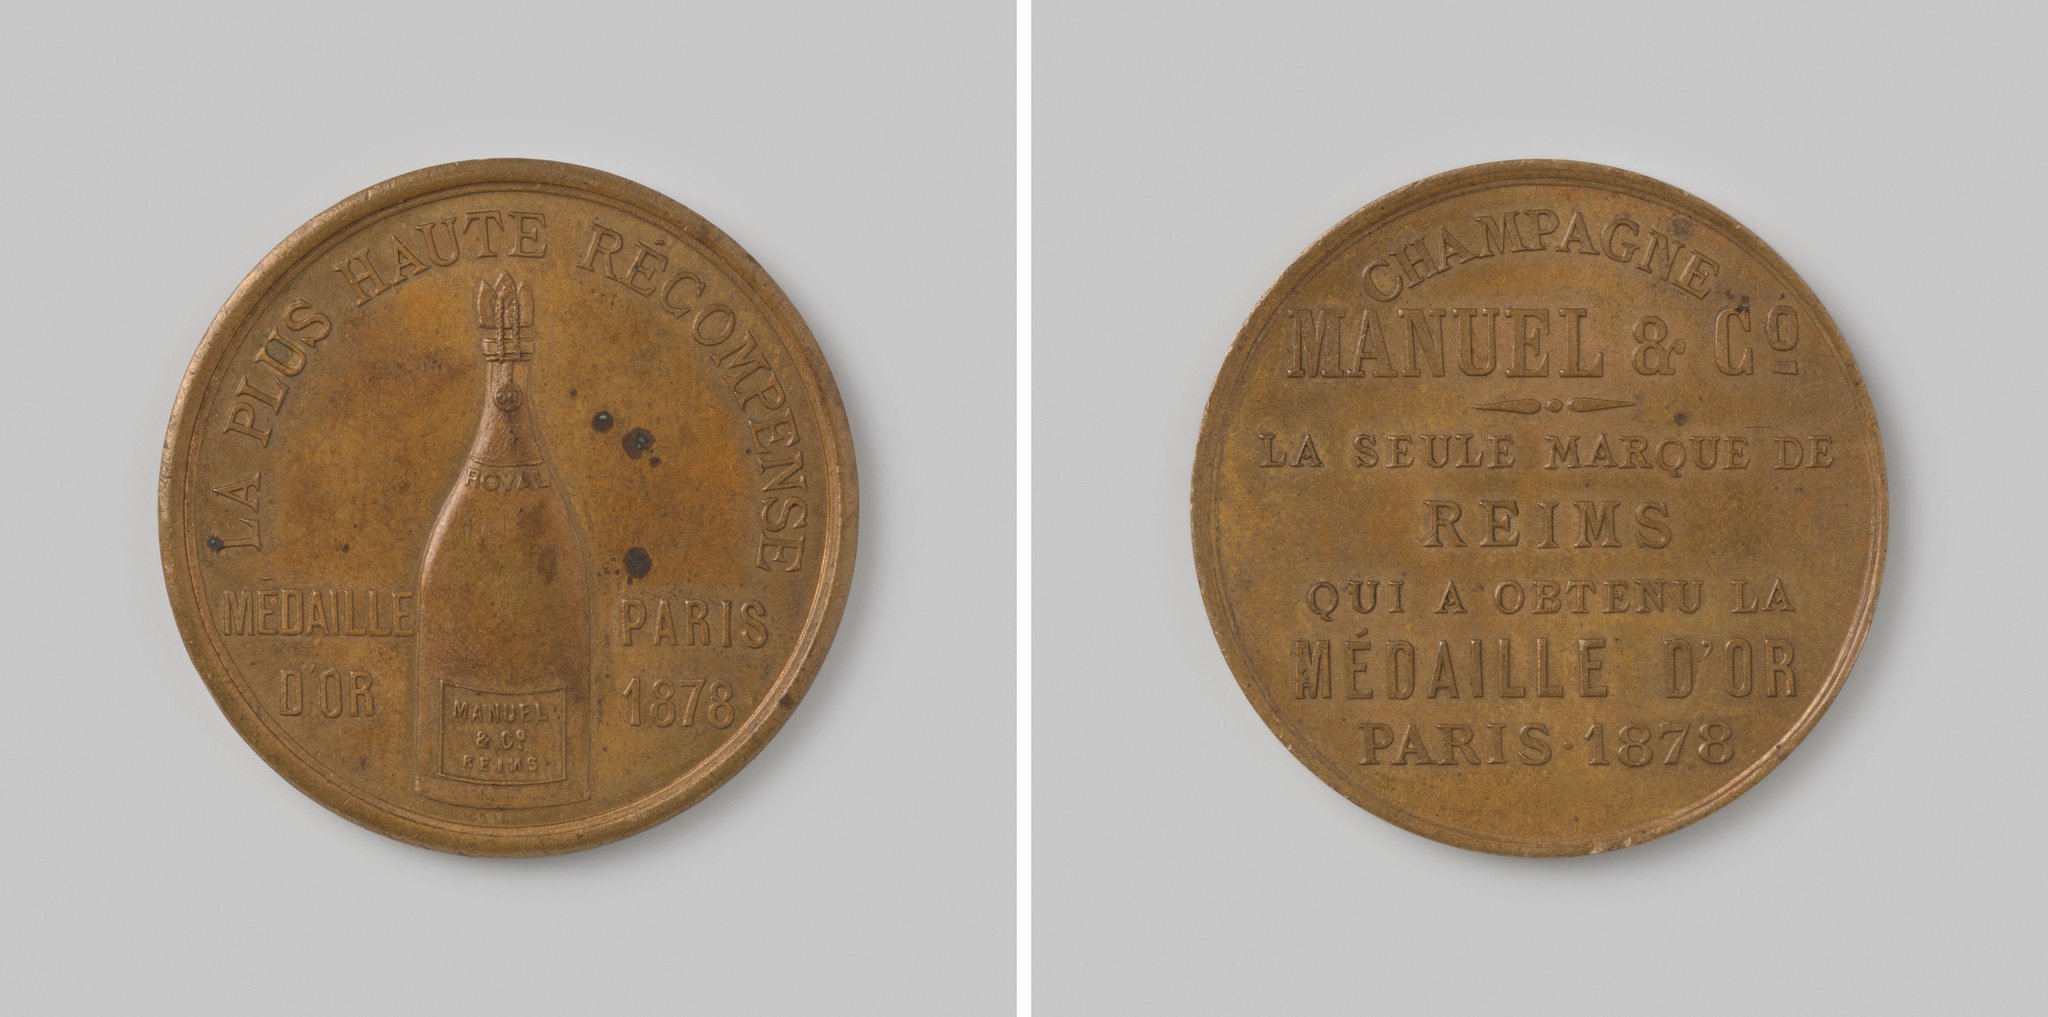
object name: history medal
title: Franse reclamepenning voor champagne Manuel & Co 1878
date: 1878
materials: bronze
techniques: striking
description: Bronzen penning, op de voorzijde een champagnefles met onderaan beiderzijds twee regels tekst, met omschrift, op de keerzijde zeven regels tekst.